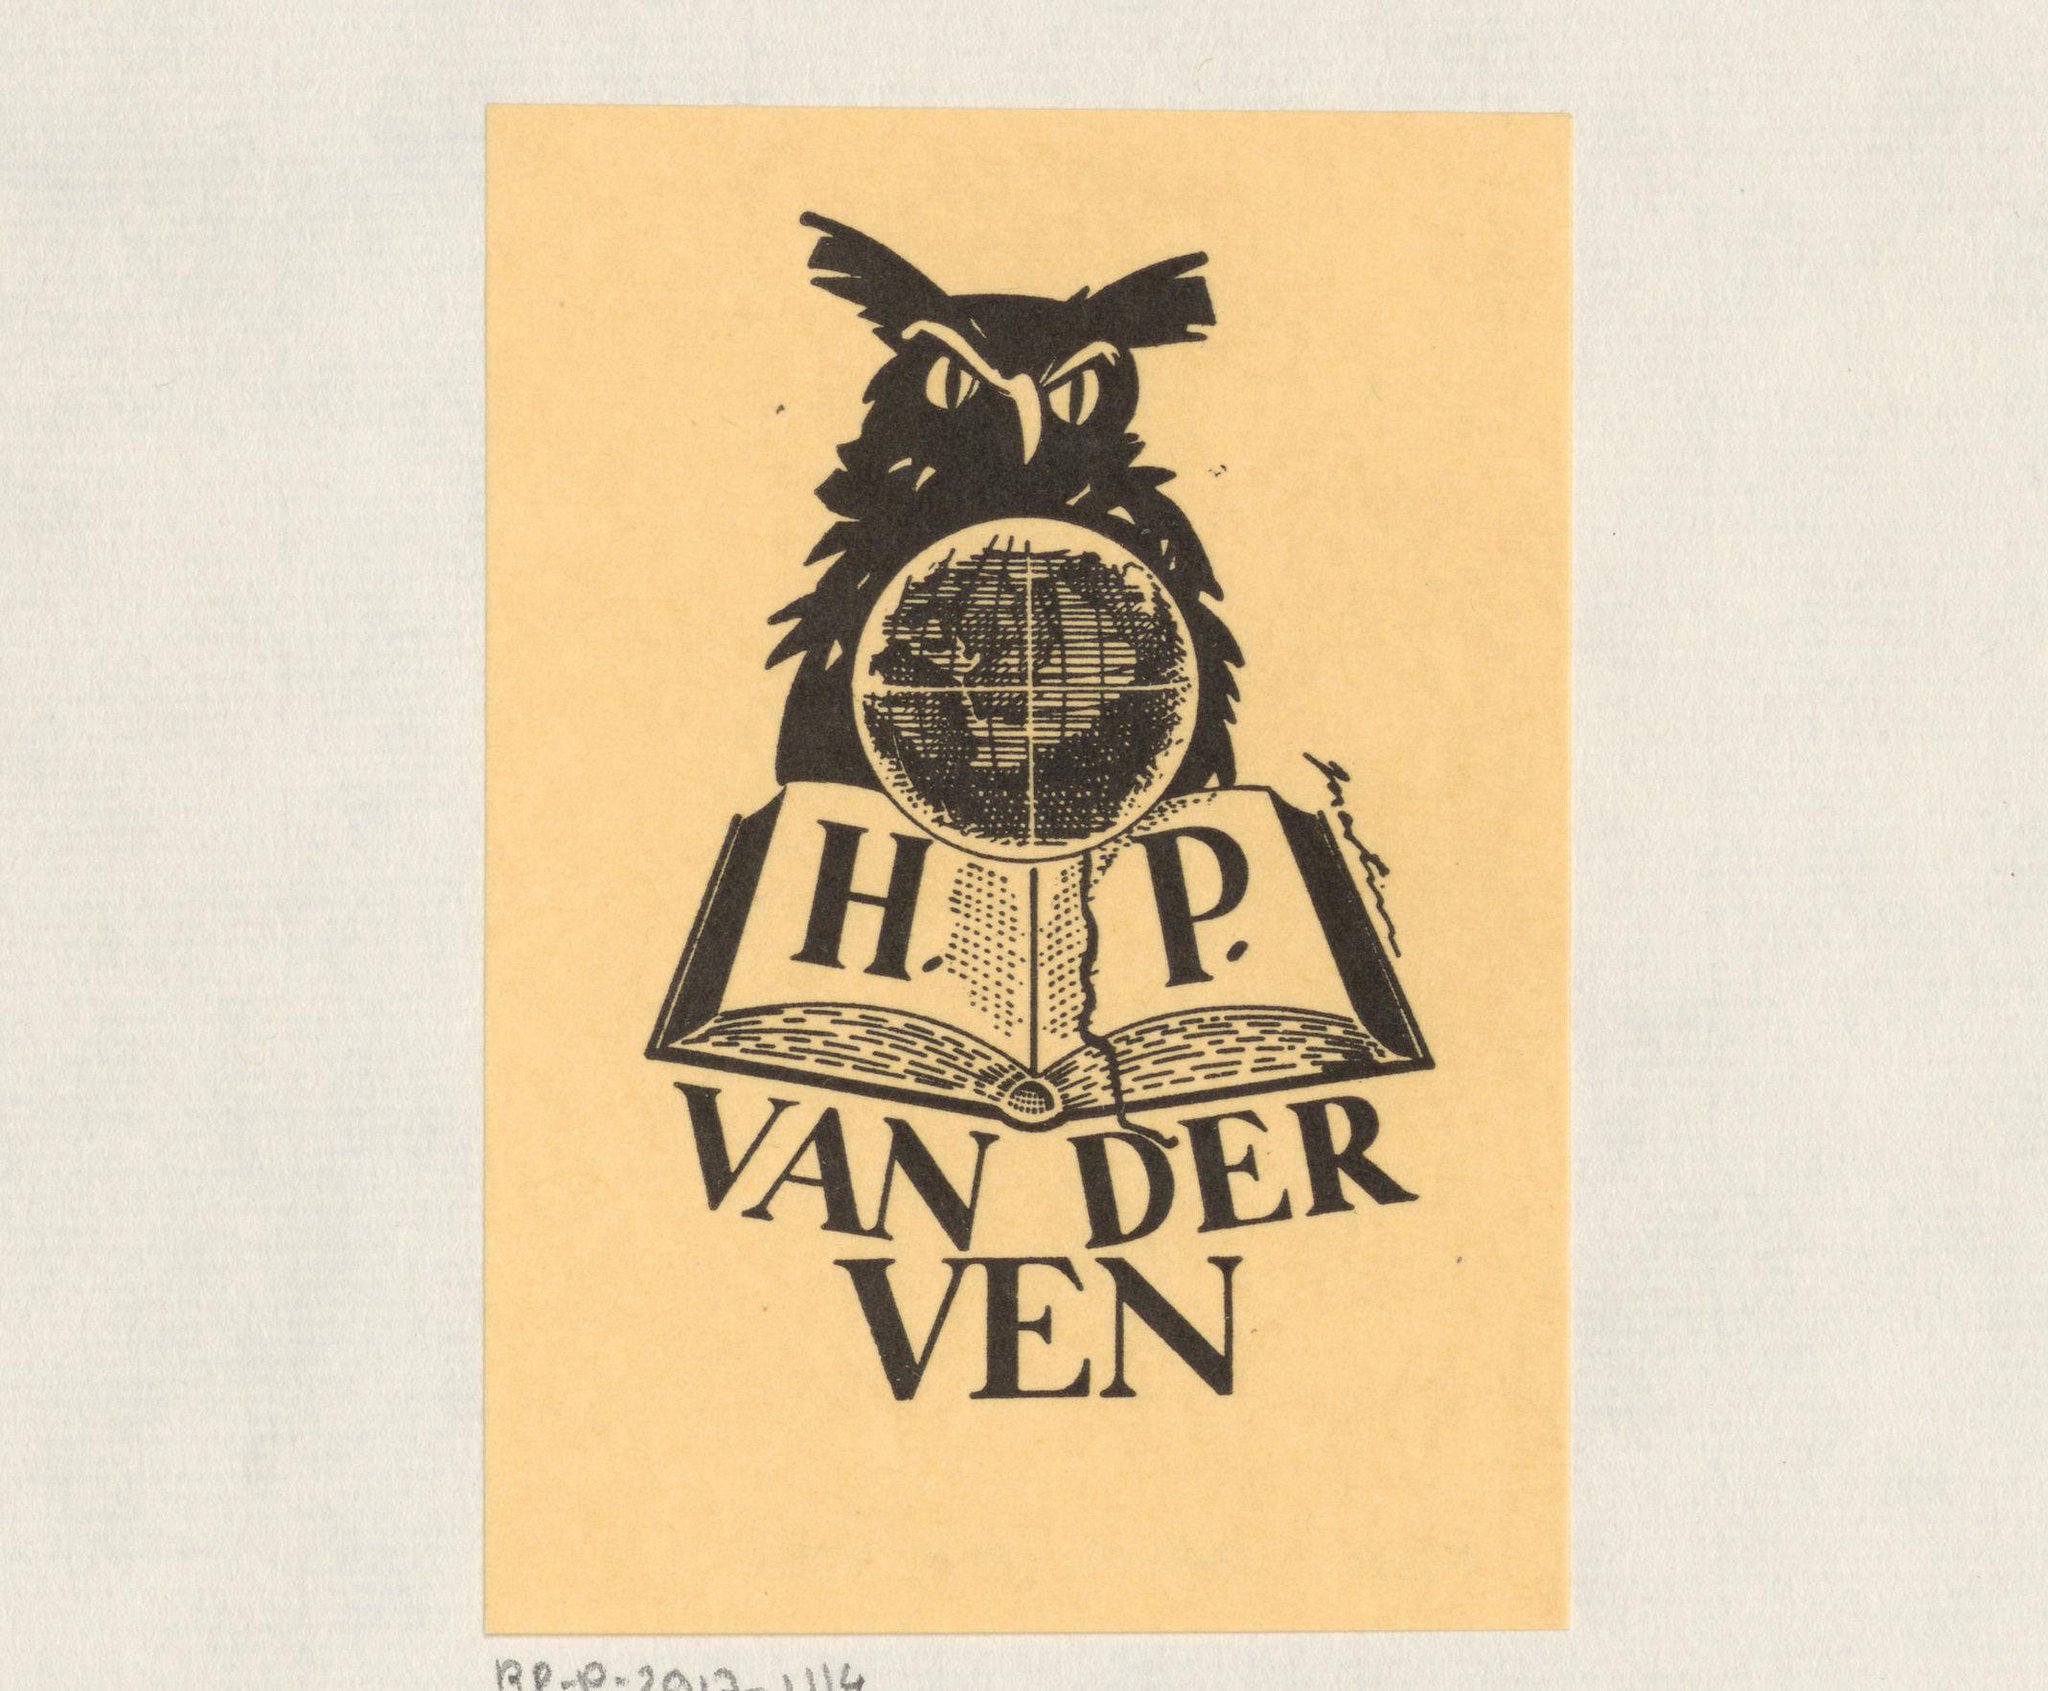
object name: bookplate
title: Ex libris van H.P. van der Ven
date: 1942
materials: paper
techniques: printing block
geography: netherlands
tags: book, owls, globe